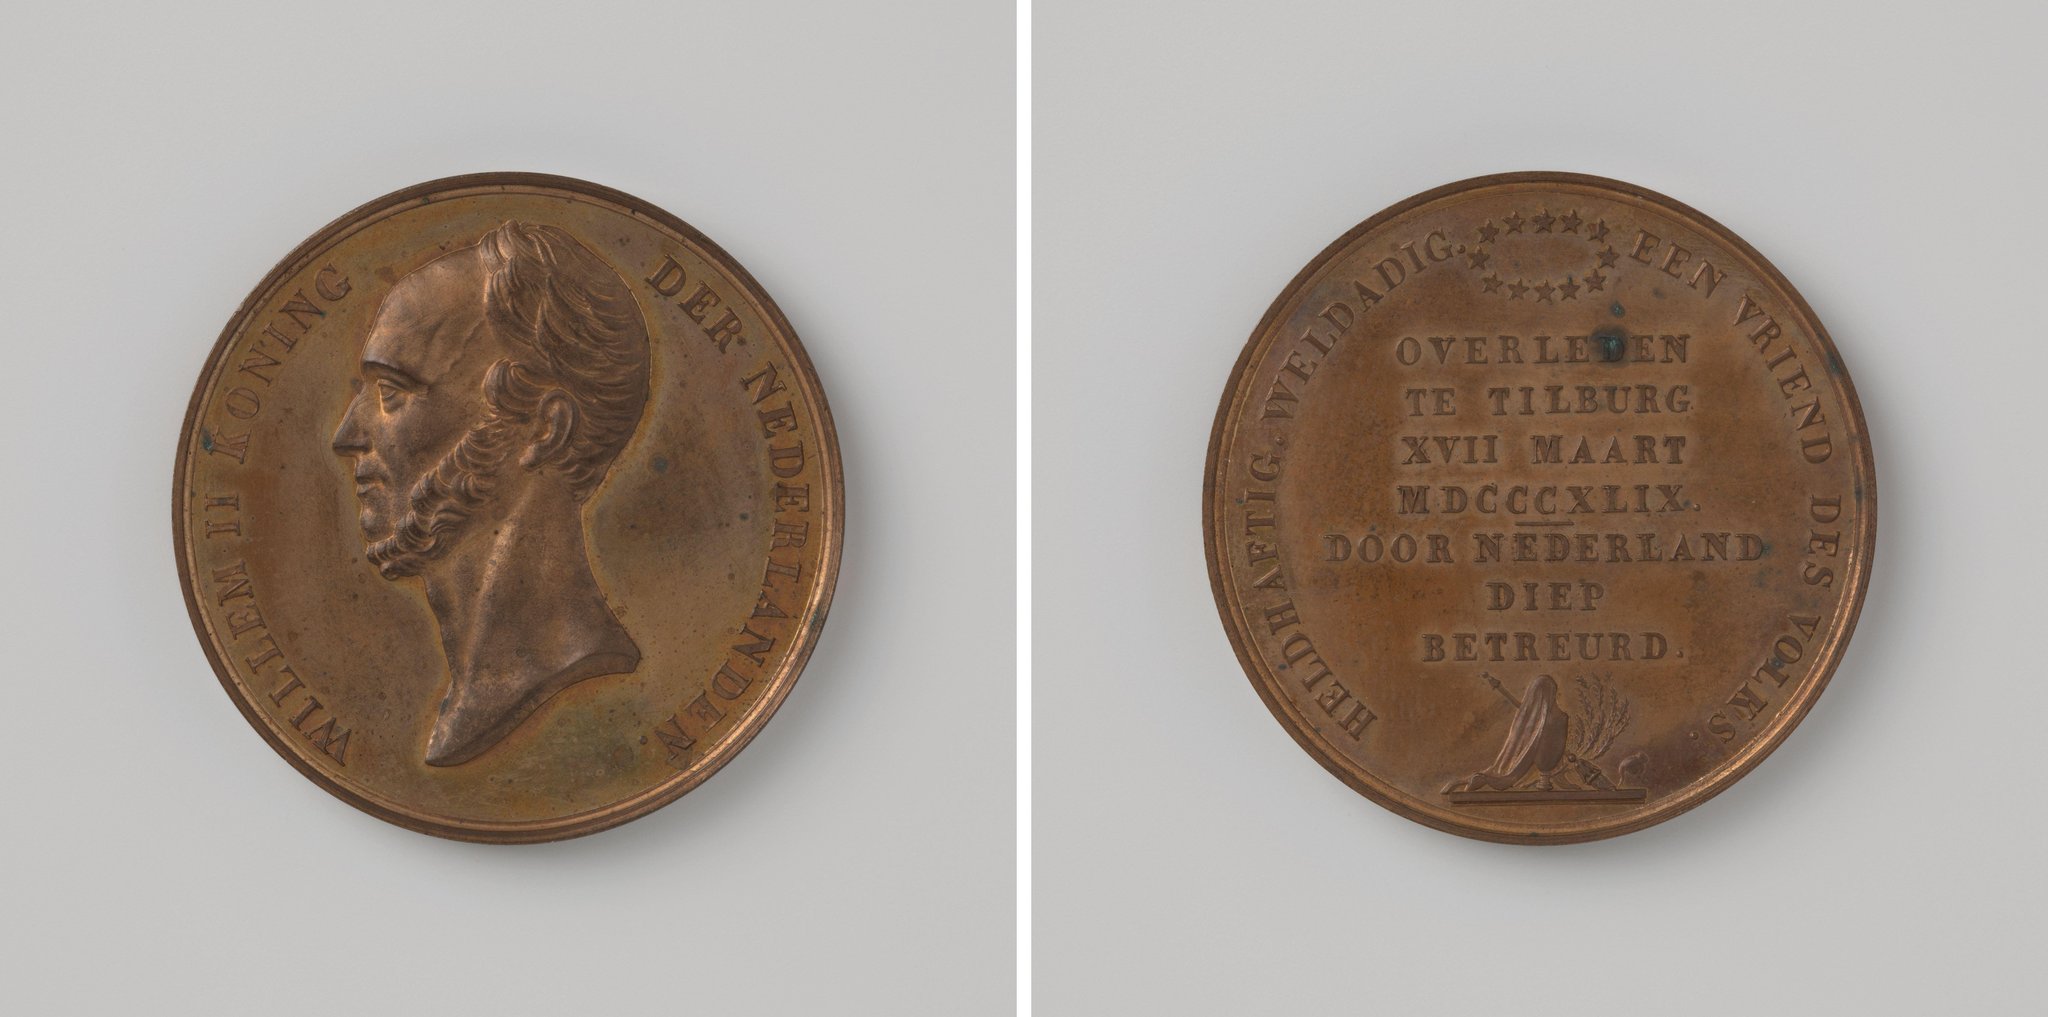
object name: history medal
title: Overlijden van Koning Willem II 1849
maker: david van der kellen (1804-1879)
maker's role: die cutter, draughtsman, print maker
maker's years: 1804-1879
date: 1849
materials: bronze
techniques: striking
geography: utrecht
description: Bronzen penning, op de voorzijde het portret van Willem II naar links met omschrift, op de keerzijde een sterrenkrans en zeven regels tekst boven een kleine asurn met gedoofde fakkel en cyprestak, met omschrift.